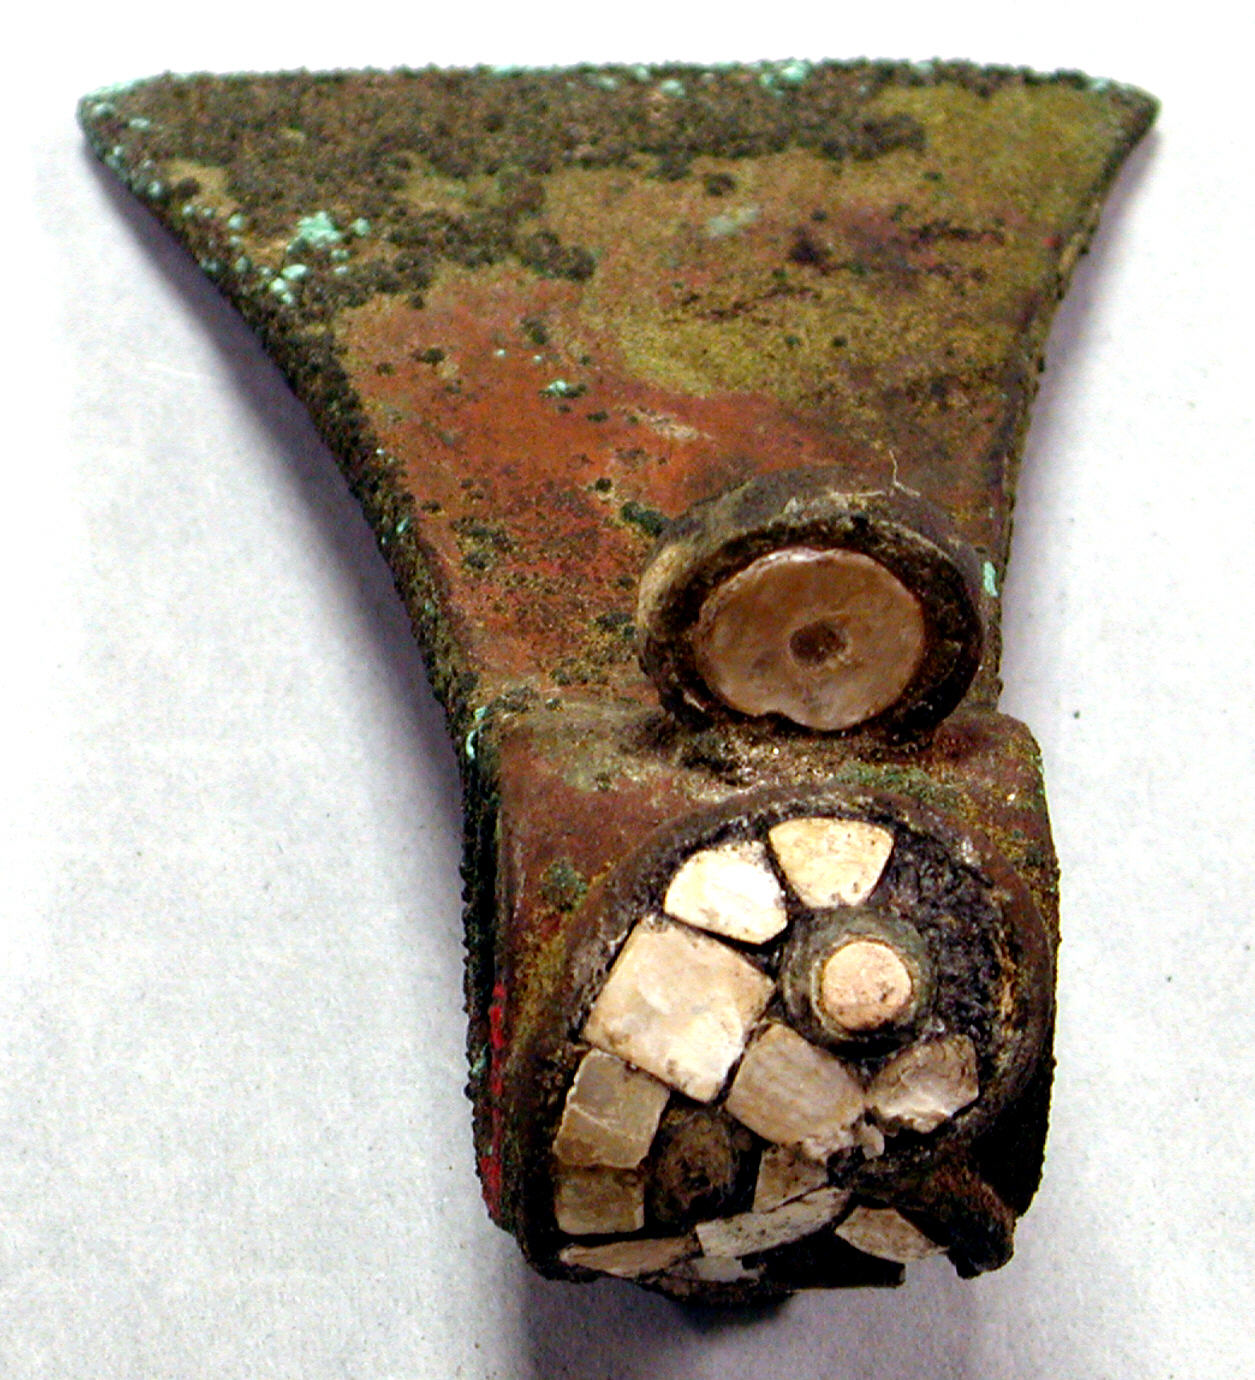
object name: axe blade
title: Copper Axe with Shells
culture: vicús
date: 300 BCE-200 CE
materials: copper, shell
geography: peru